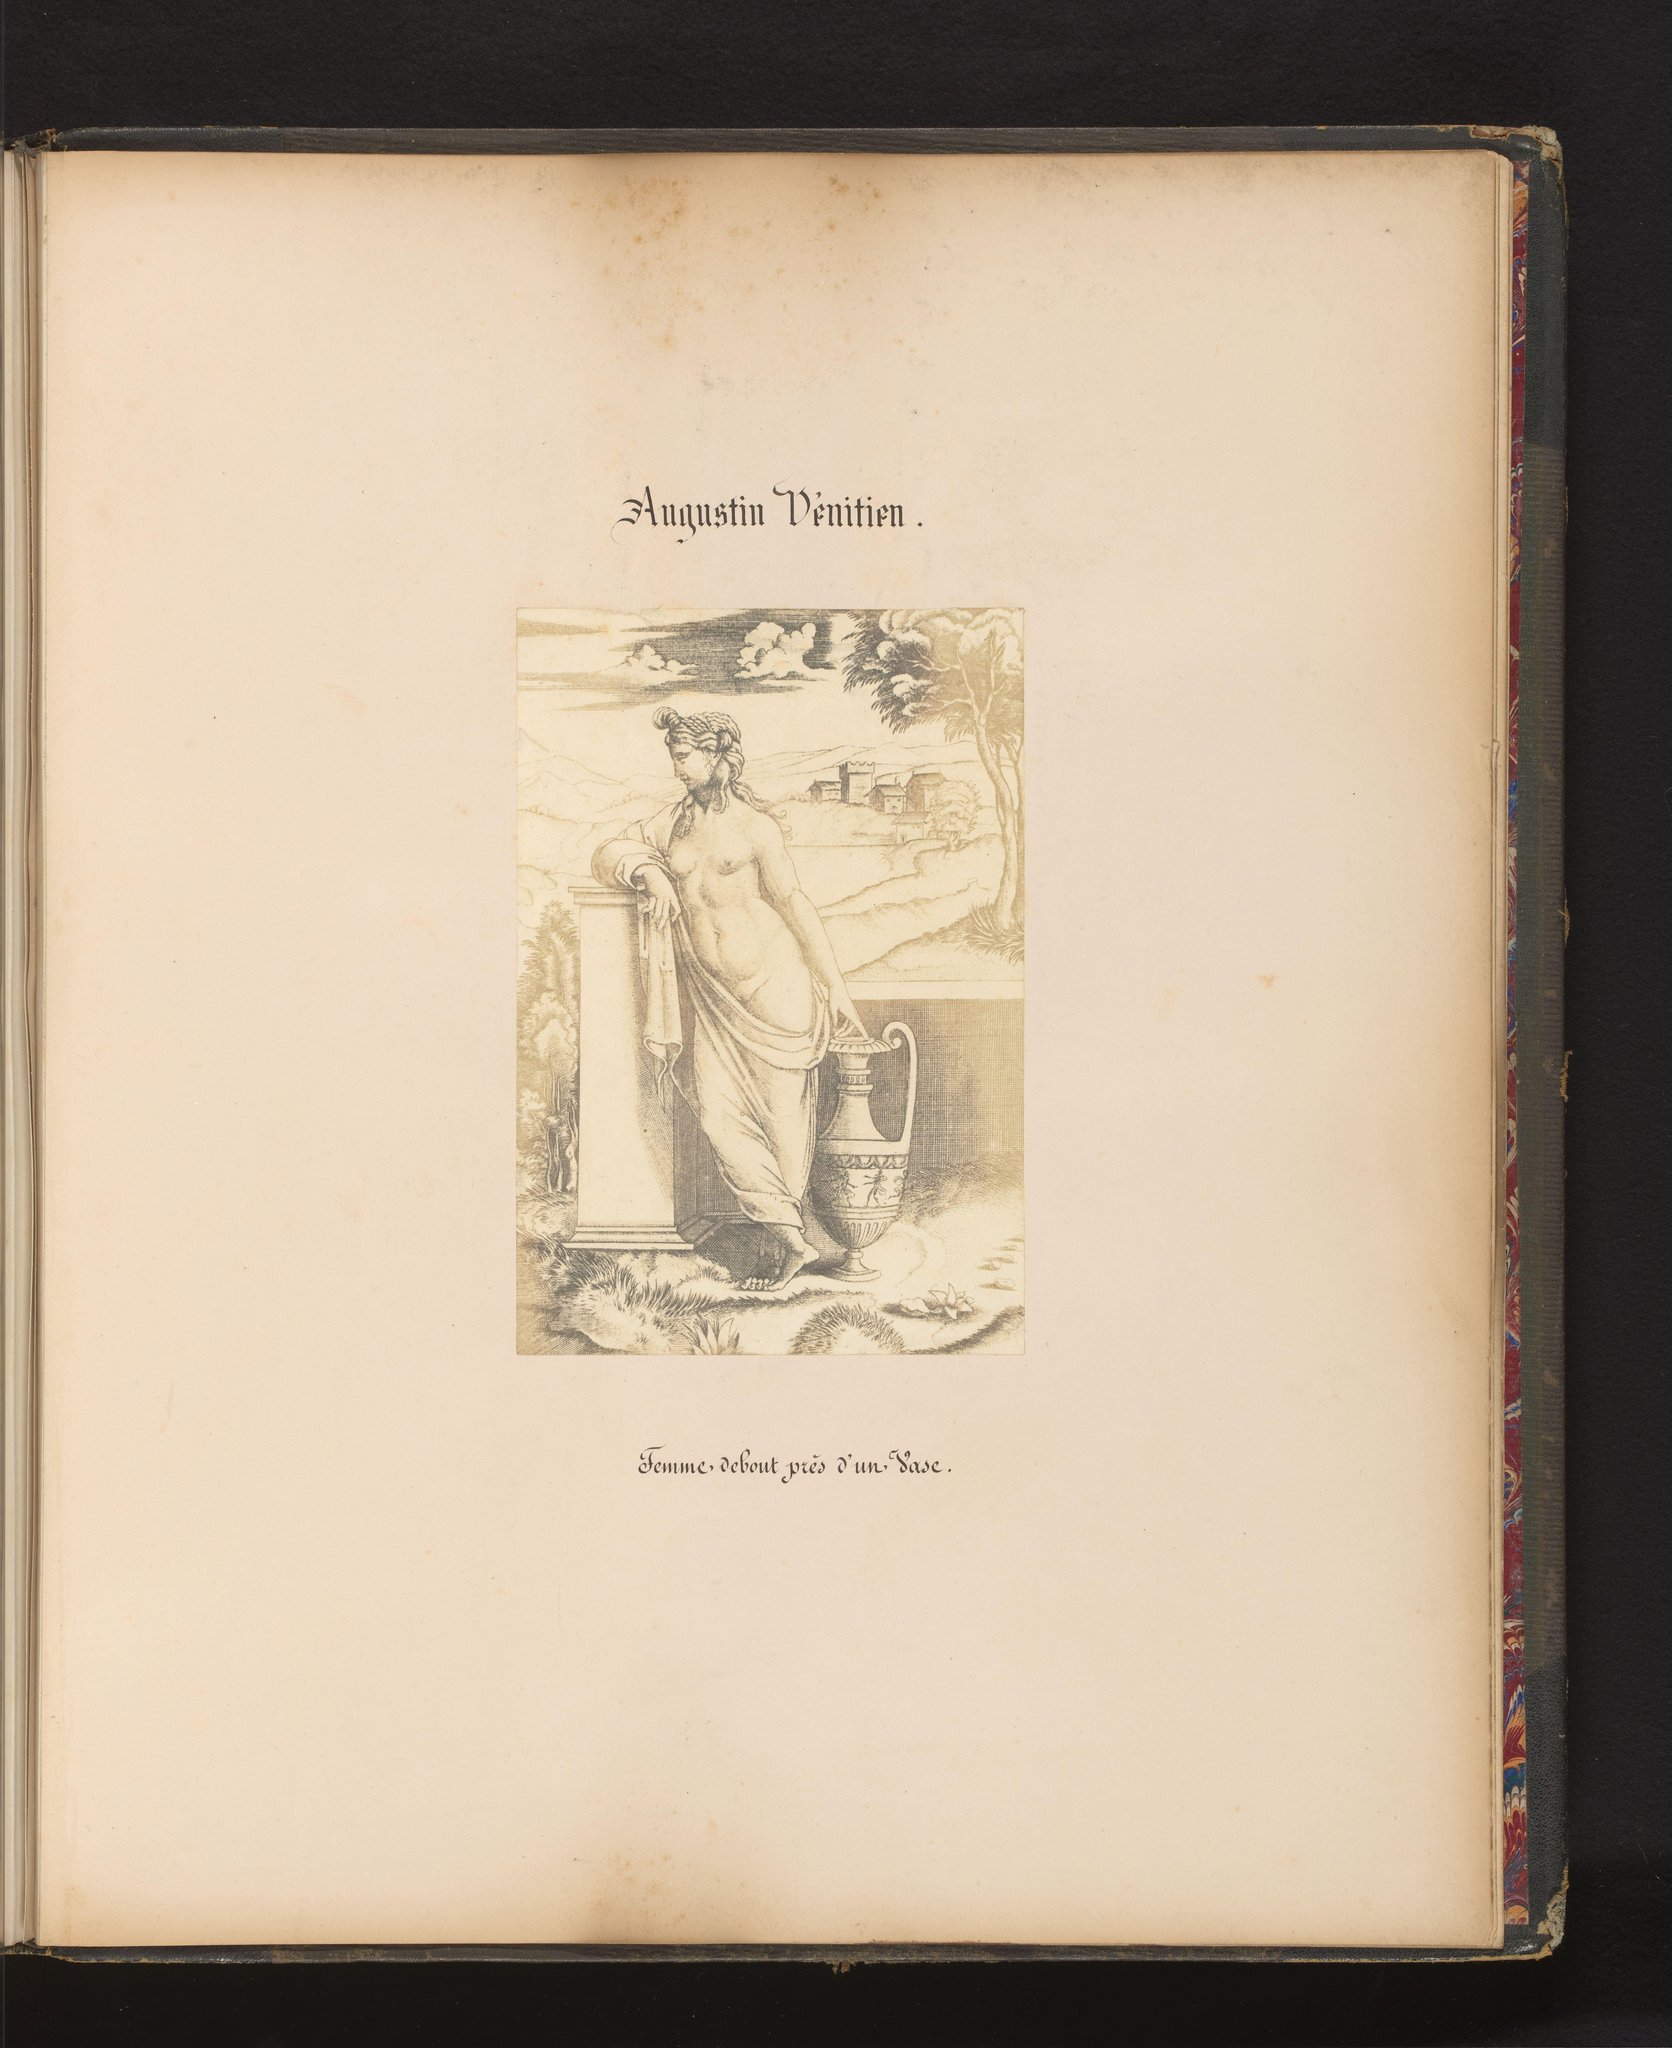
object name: page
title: Augustin Vénetien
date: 1848-1853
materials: photographic support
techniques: salted paper print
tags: standing figure - aa - female human figure, container of ceramics: jar, jug, pot, vase